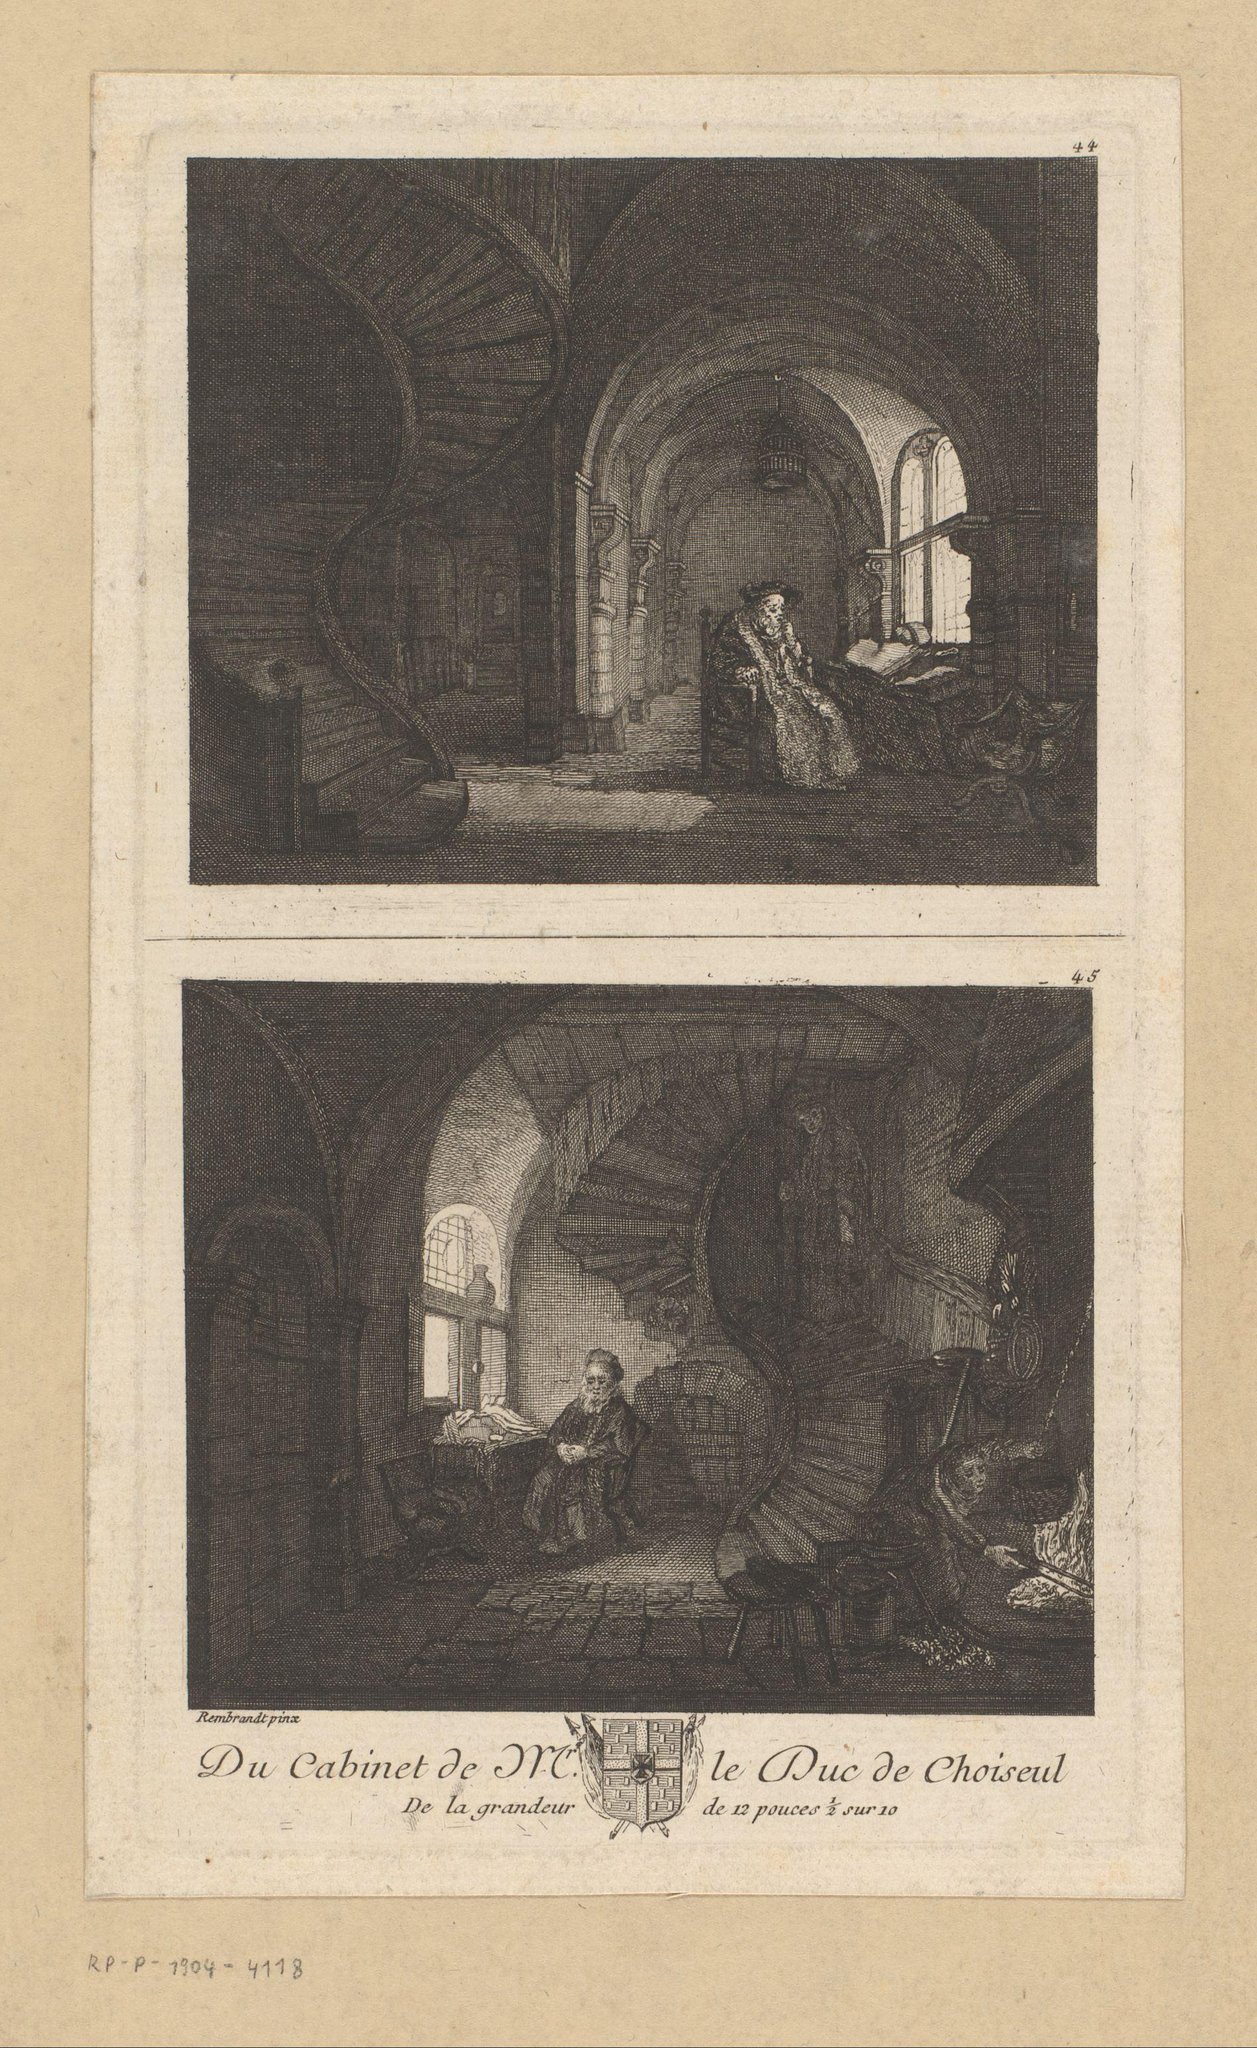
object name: print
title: Twee studievertrekken met geleerden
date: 1750-1780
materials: paper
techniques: engraving, etching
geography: france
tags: scholar in his study, armorial bearing, heraldry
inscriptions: collector's mark: Lugt 2228